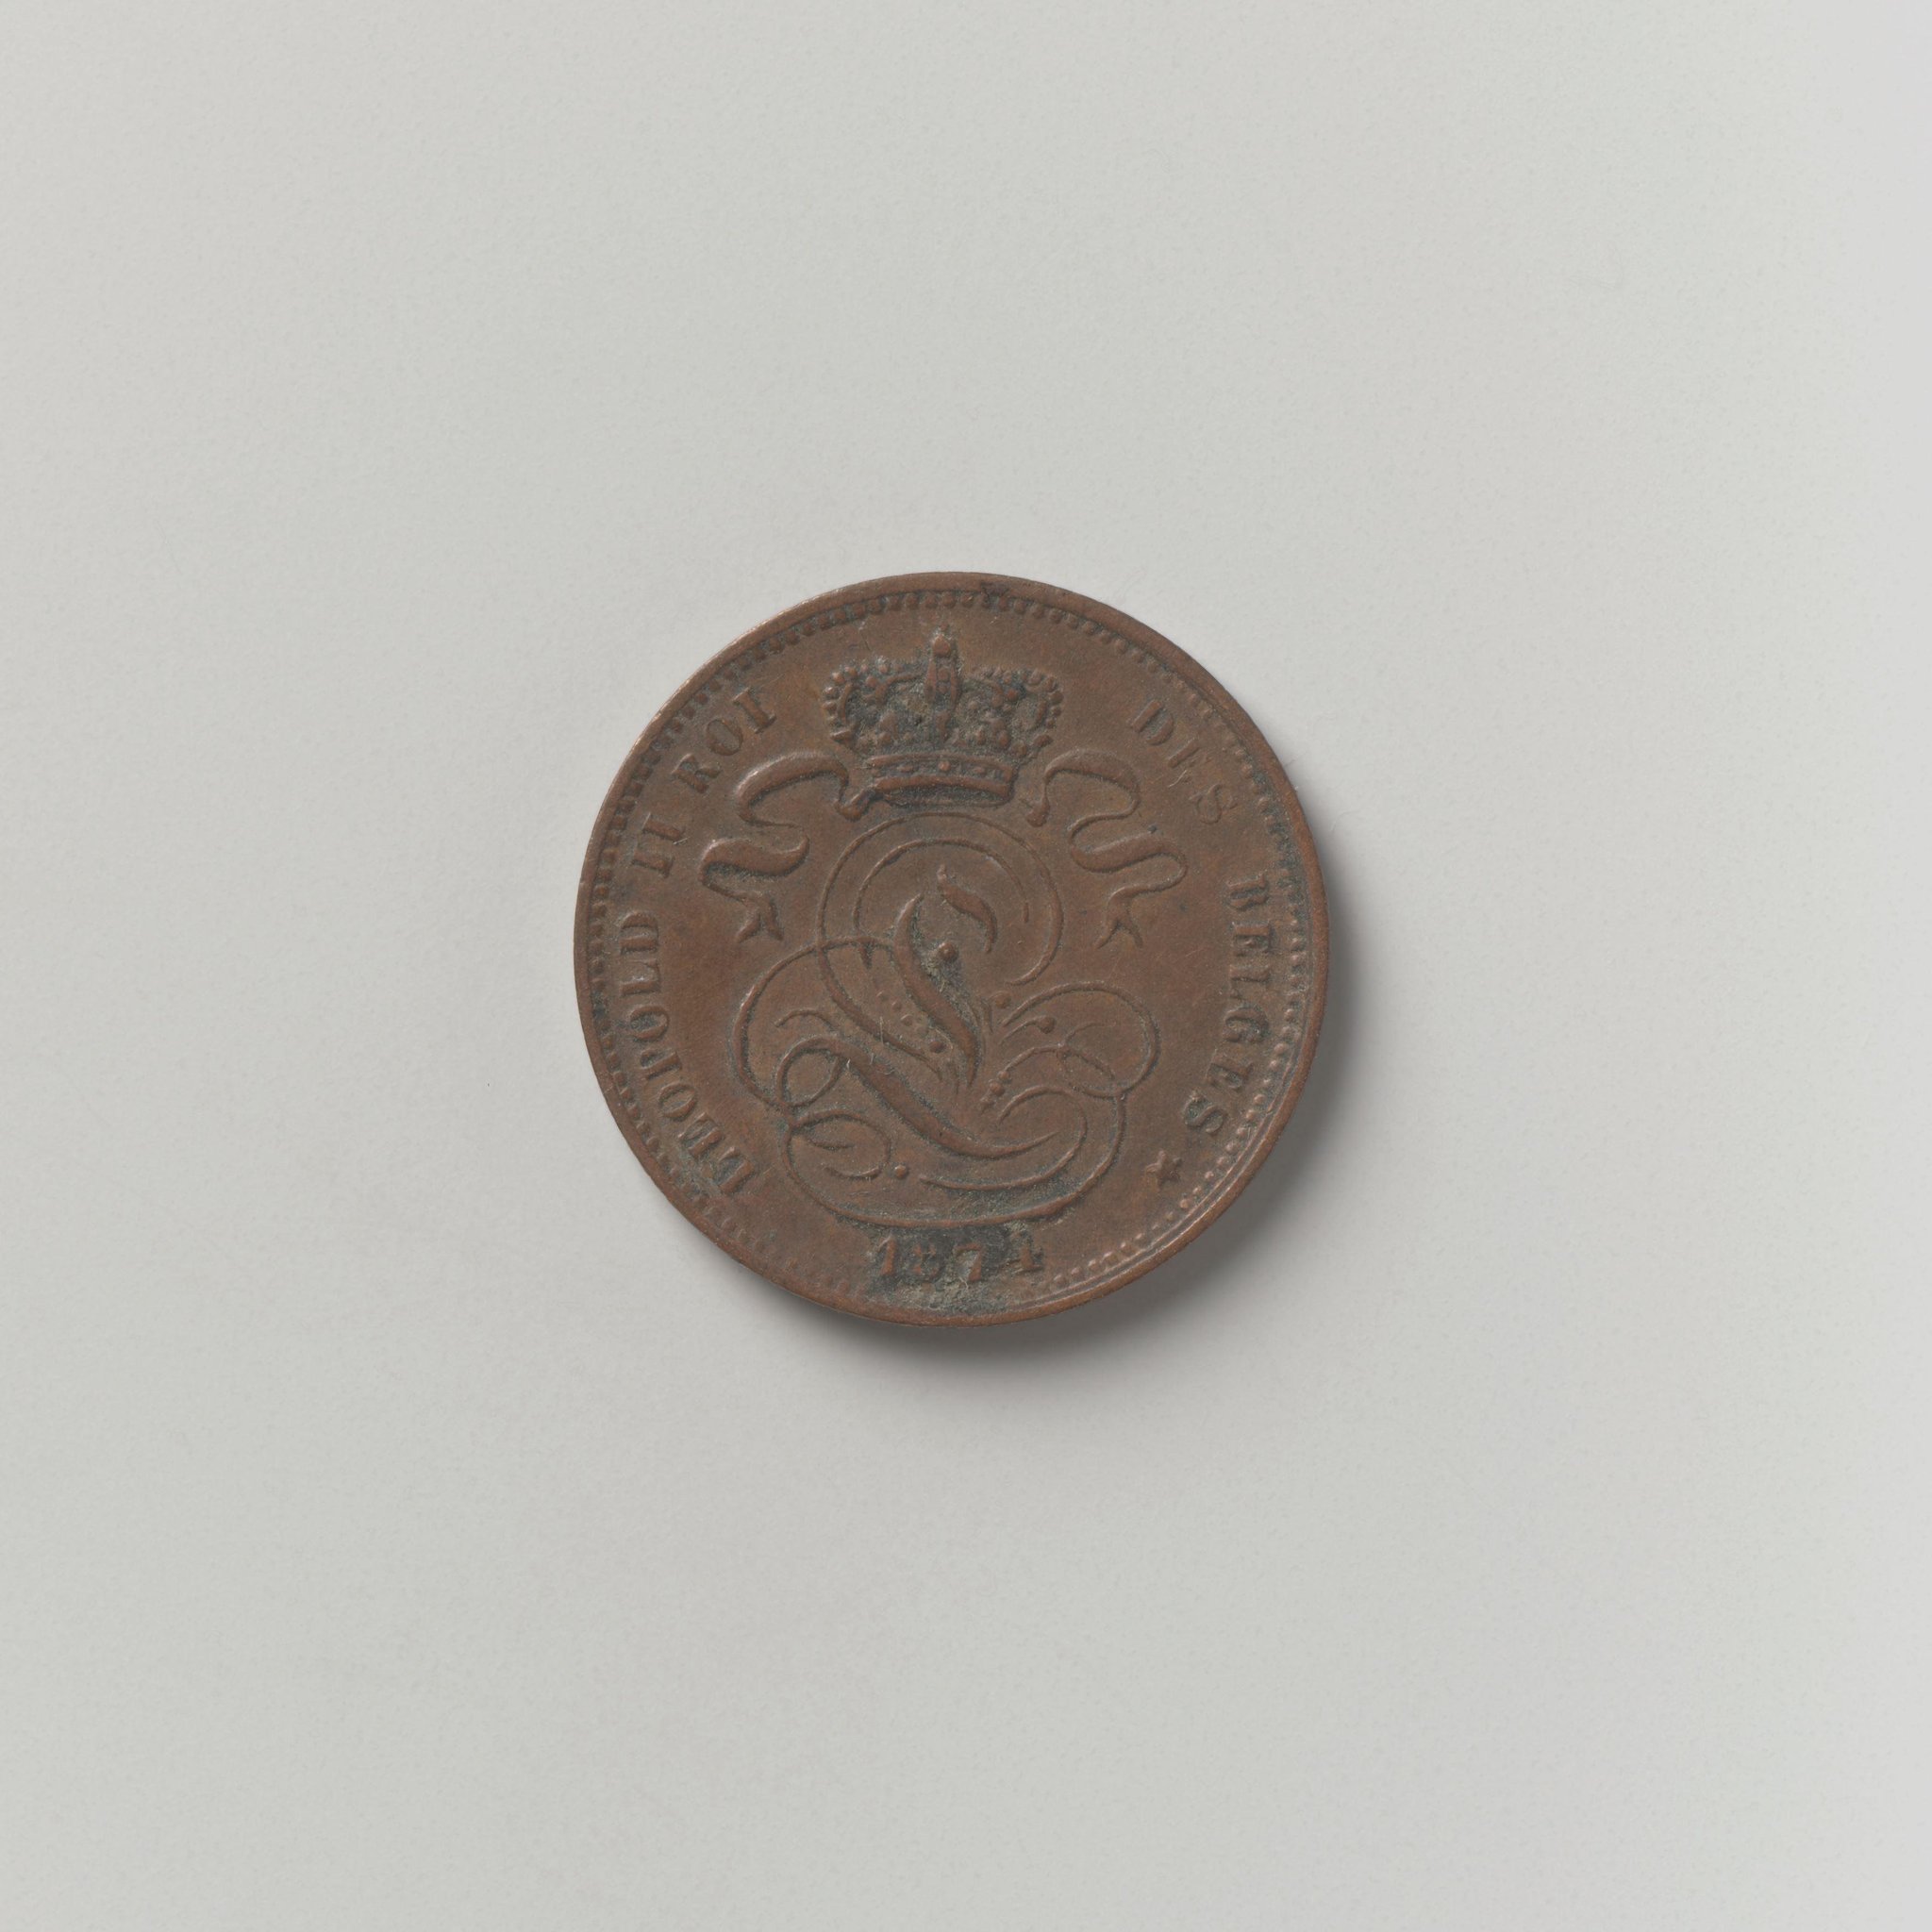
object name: coin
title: centime uit België van Leopold II, 1874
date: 1874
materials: copper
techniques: striking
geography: brussels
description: Koperen munt. Voorzijde: zittende, omkijkende leeuw naar links met onder rechter klauw paneel met opschrift. In afsnede waarde-aanduiding. Keerzijde: gekroond monogram. Jaartal onderaan. Kartelrand.